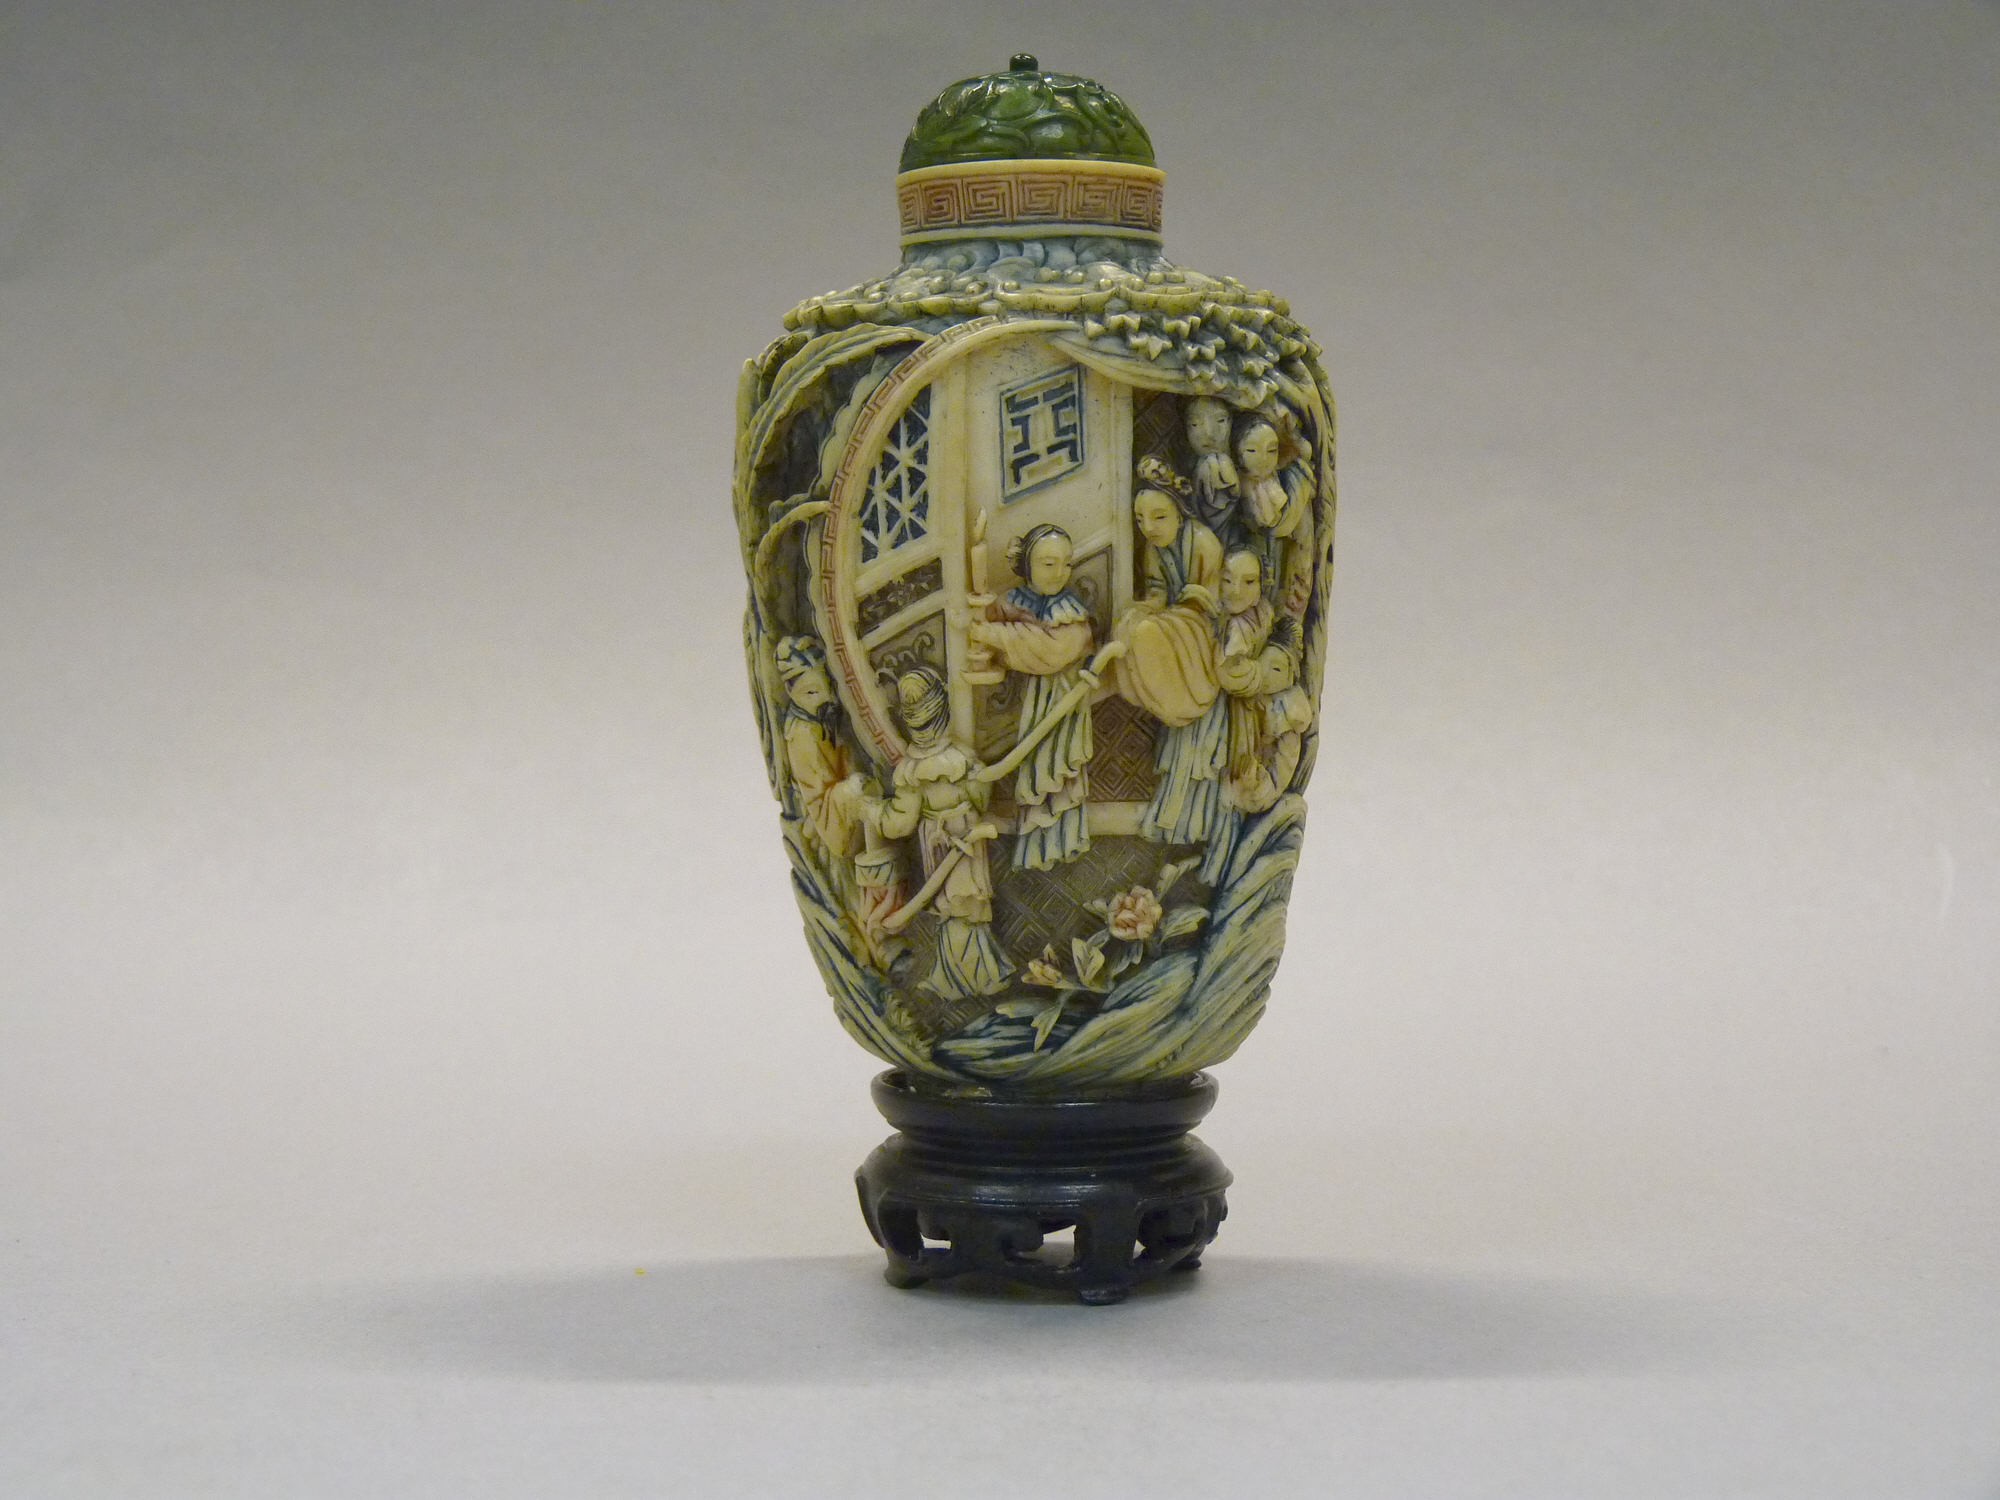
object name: snuff bottle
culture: chinese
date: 1736-1795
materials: ivory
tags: men,women